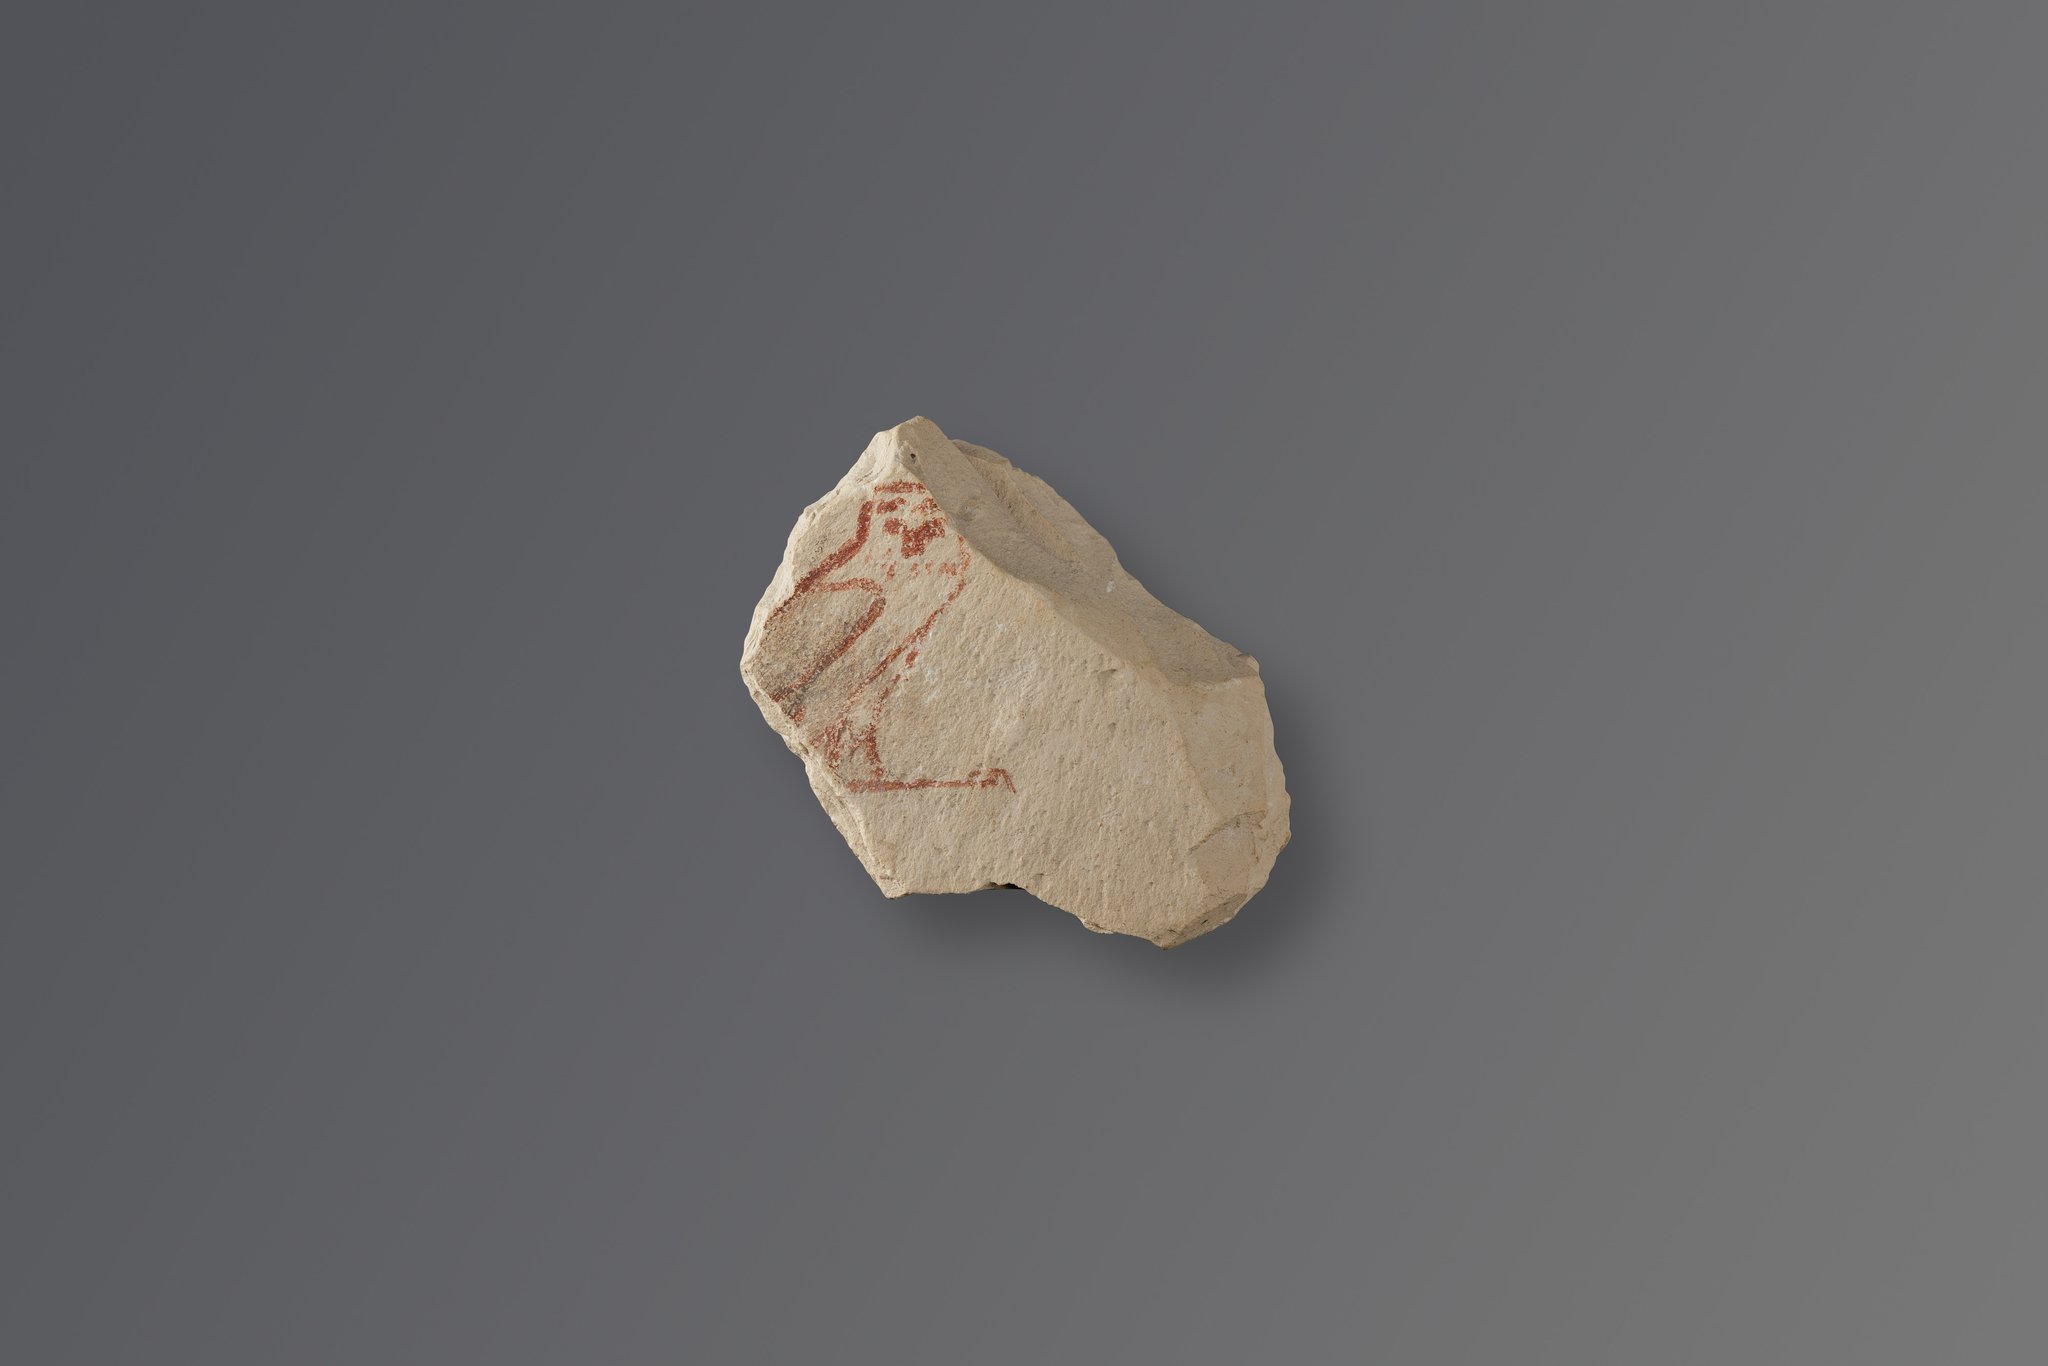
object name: relief drawing, sebeknakhte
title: Preliminary drawing for a relief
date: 2124-1504 BCE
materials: limestone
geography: egypt